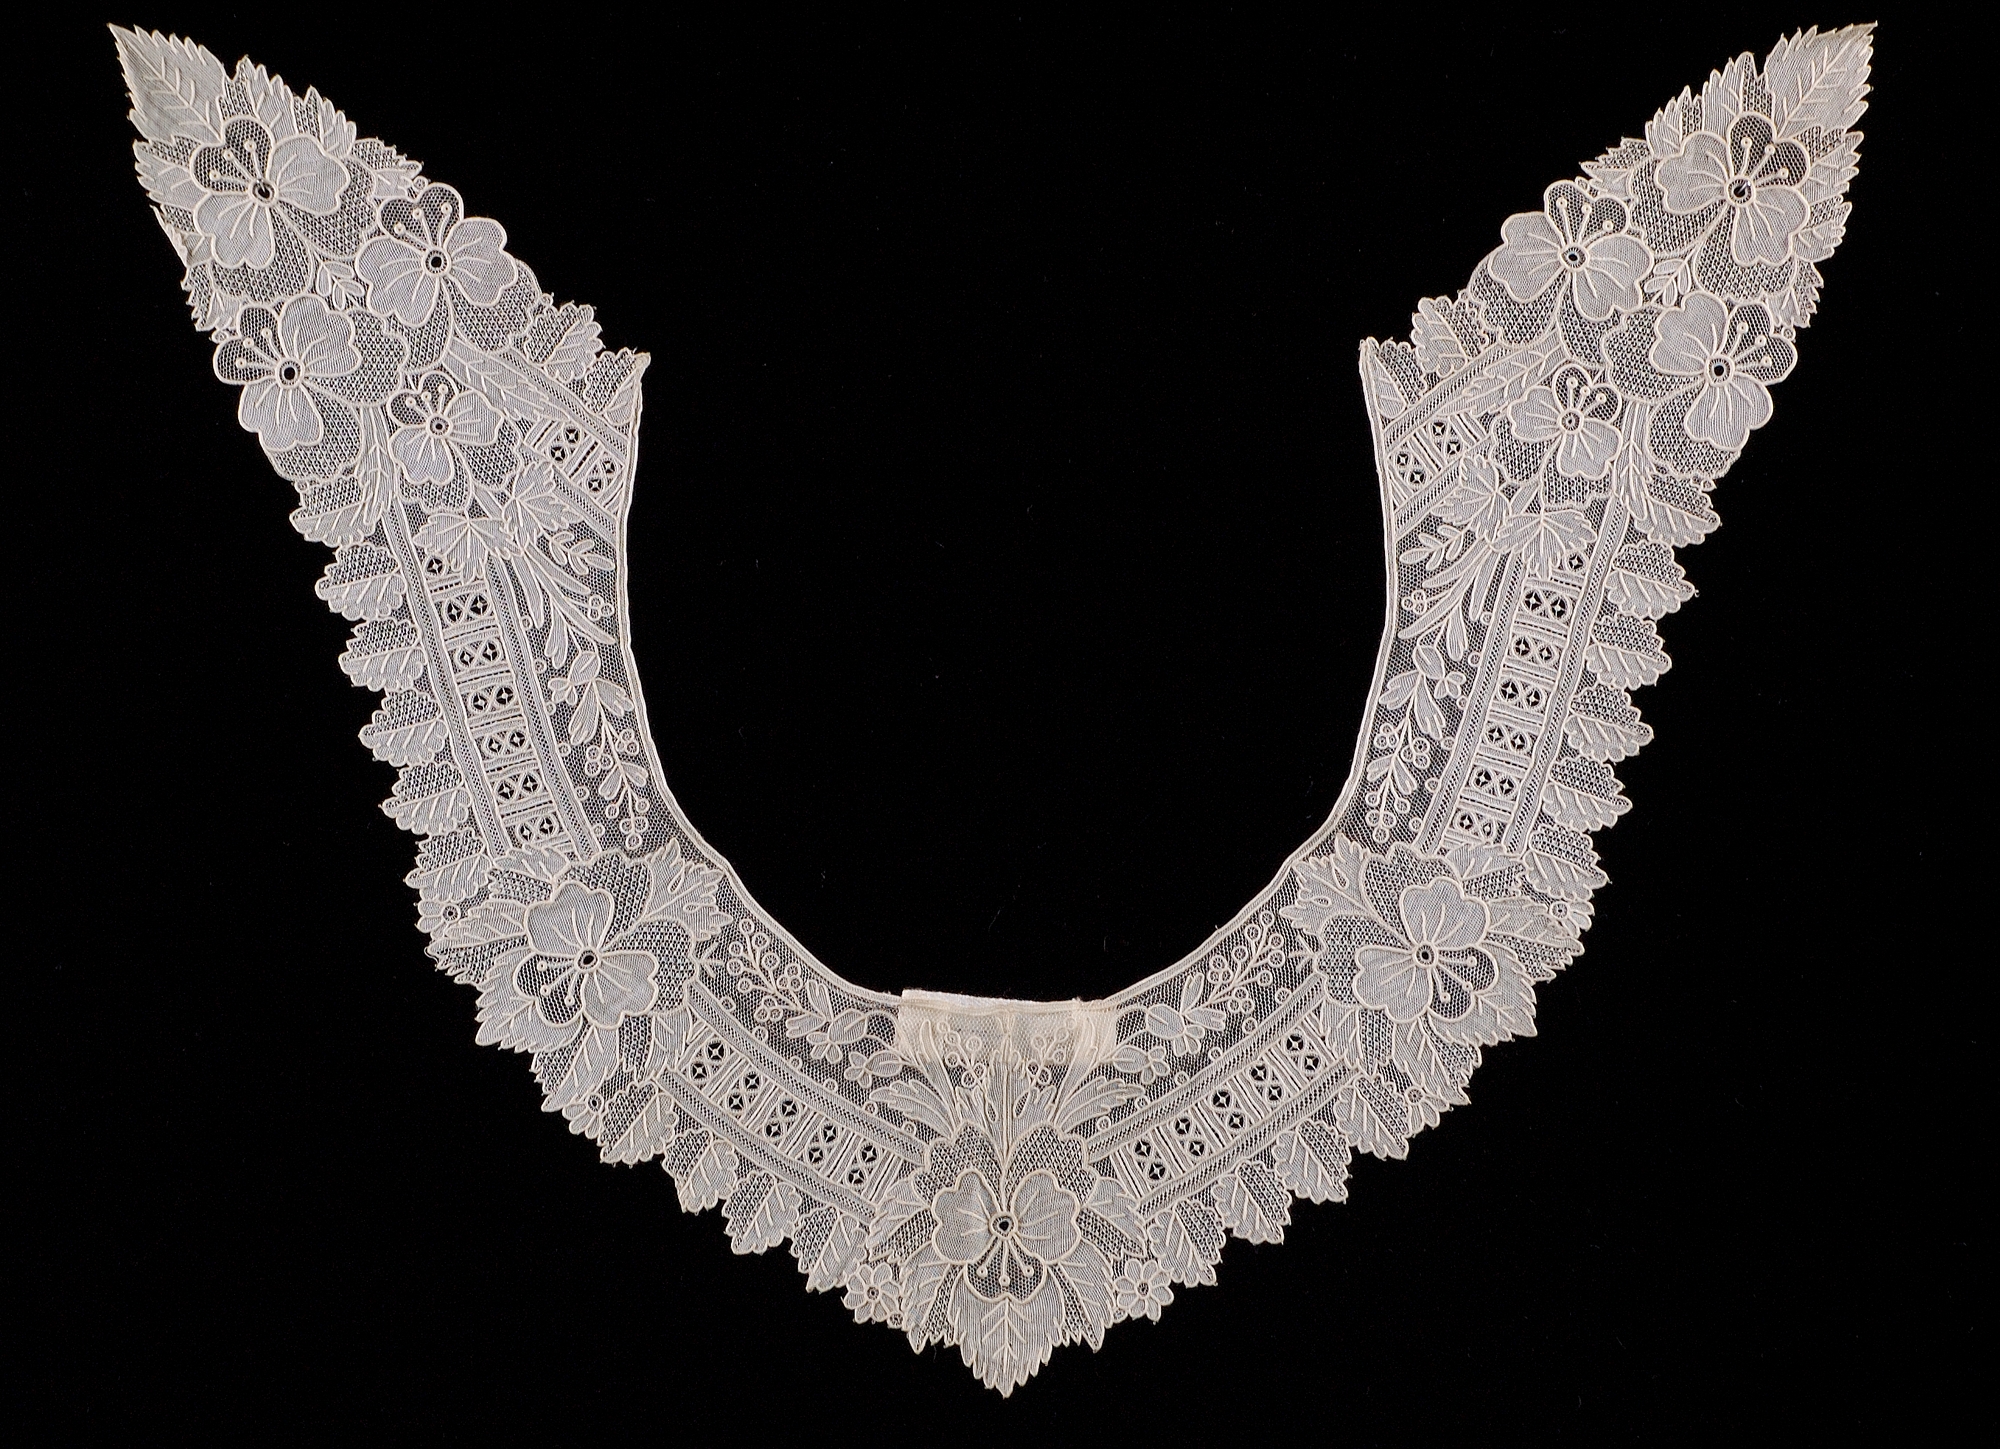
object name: collar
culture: american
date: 1860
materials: linen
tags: flowers